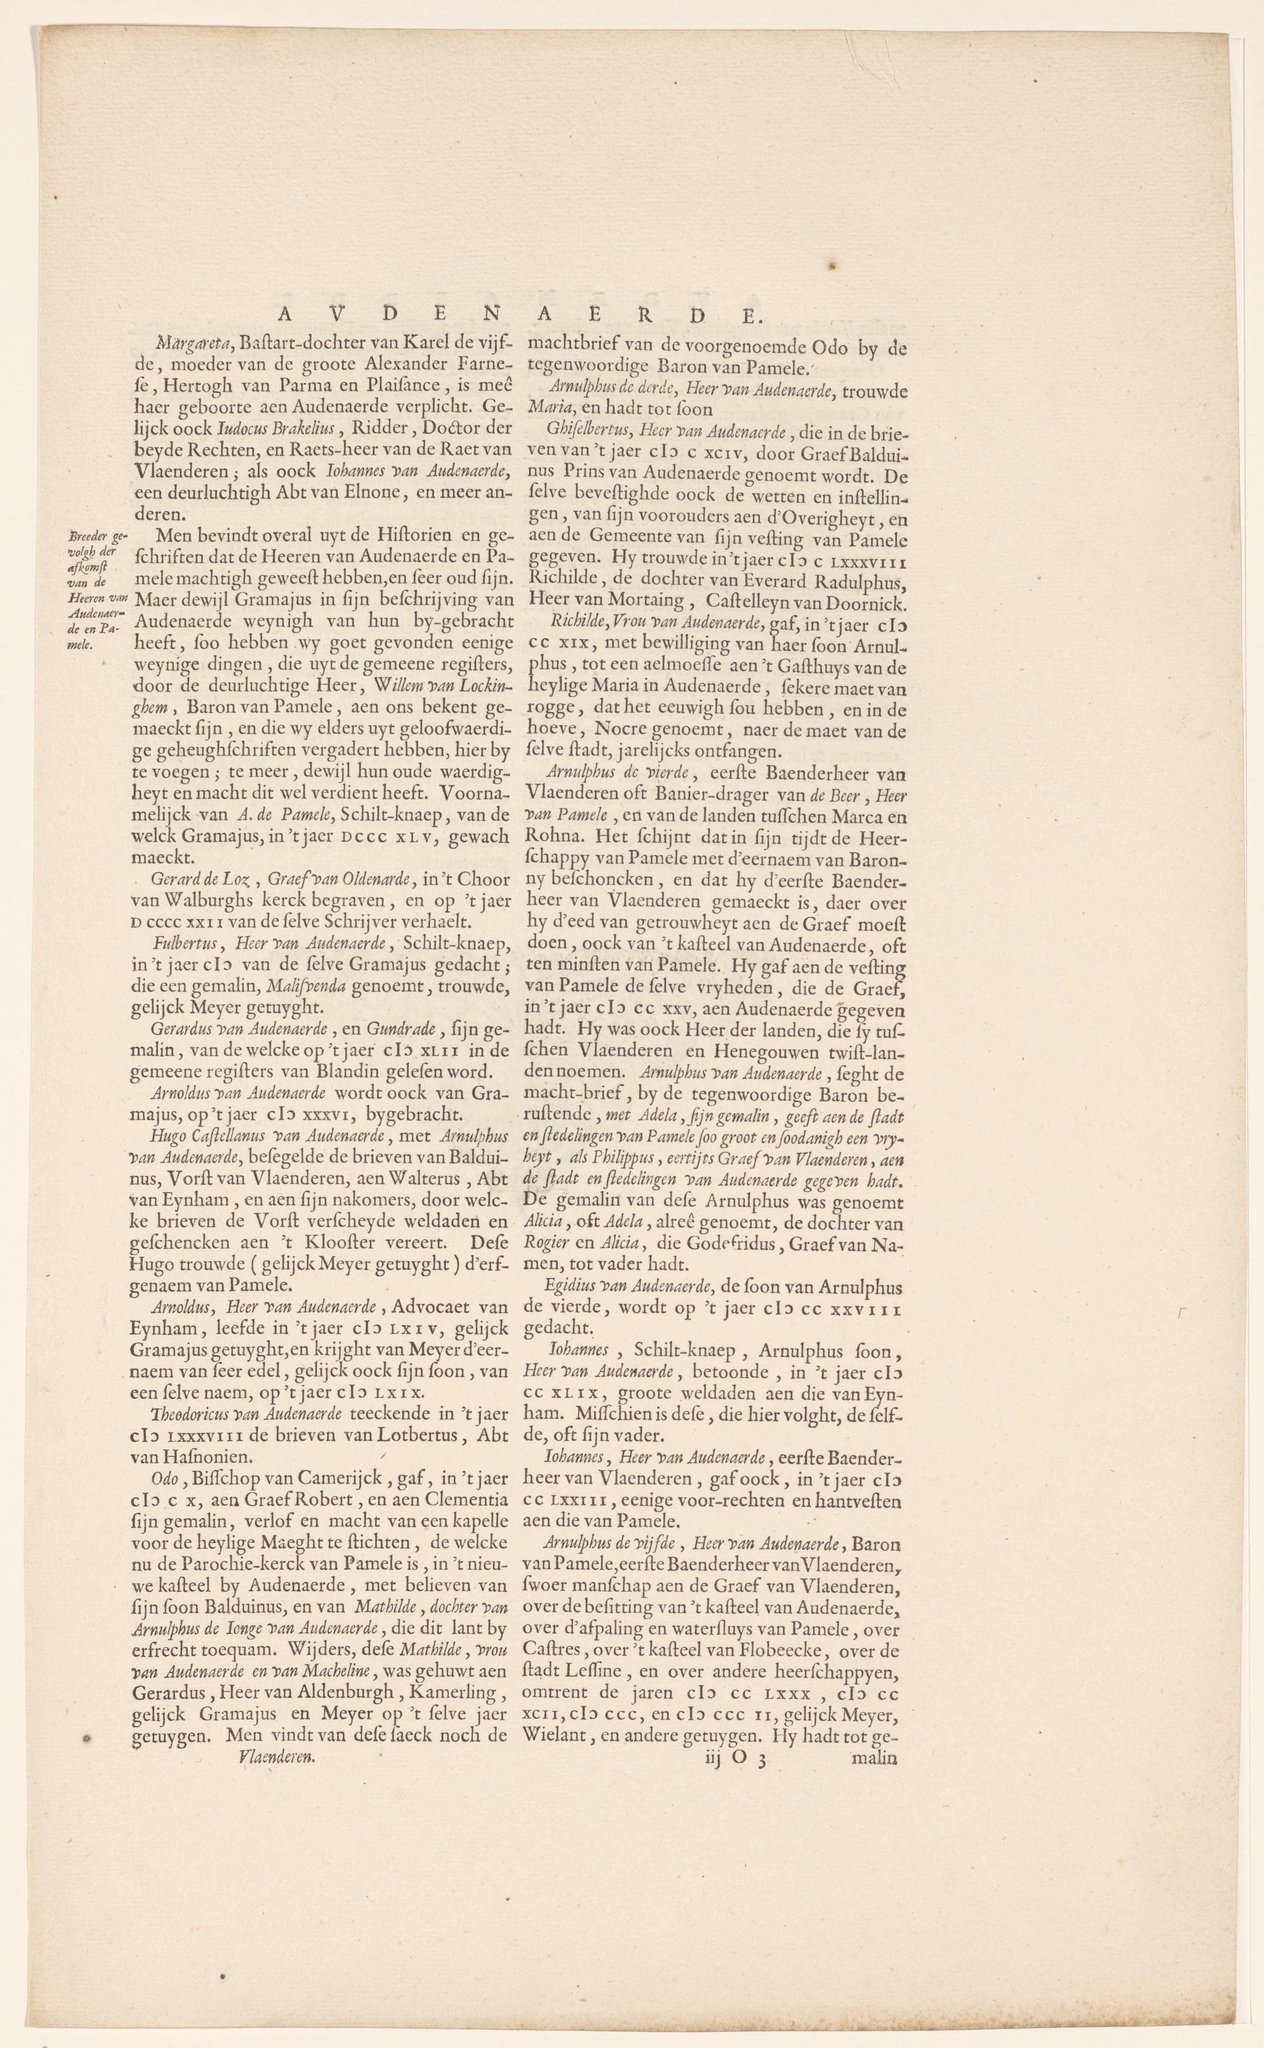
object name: text sheet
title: Deel van de beschrijving van Oudenaarde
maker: johannes willemszoon blaeu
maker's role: printer, publisher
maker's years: 1596-1673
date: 1652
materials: paper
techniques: letterpress printing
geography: amsterdam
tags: oudenaarde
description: Tekst gebruikt in: Blaeu, Johannes Willemszoon. Toonneel der steden van de Vereenighde Nederlanden. 2 delen. Amsterdam: Johannes Willemszoon Blaeu, 1652, dl. 2. Zie ook: RP-P-AO-18-211-1 en RP-P-AO-18-211-2.